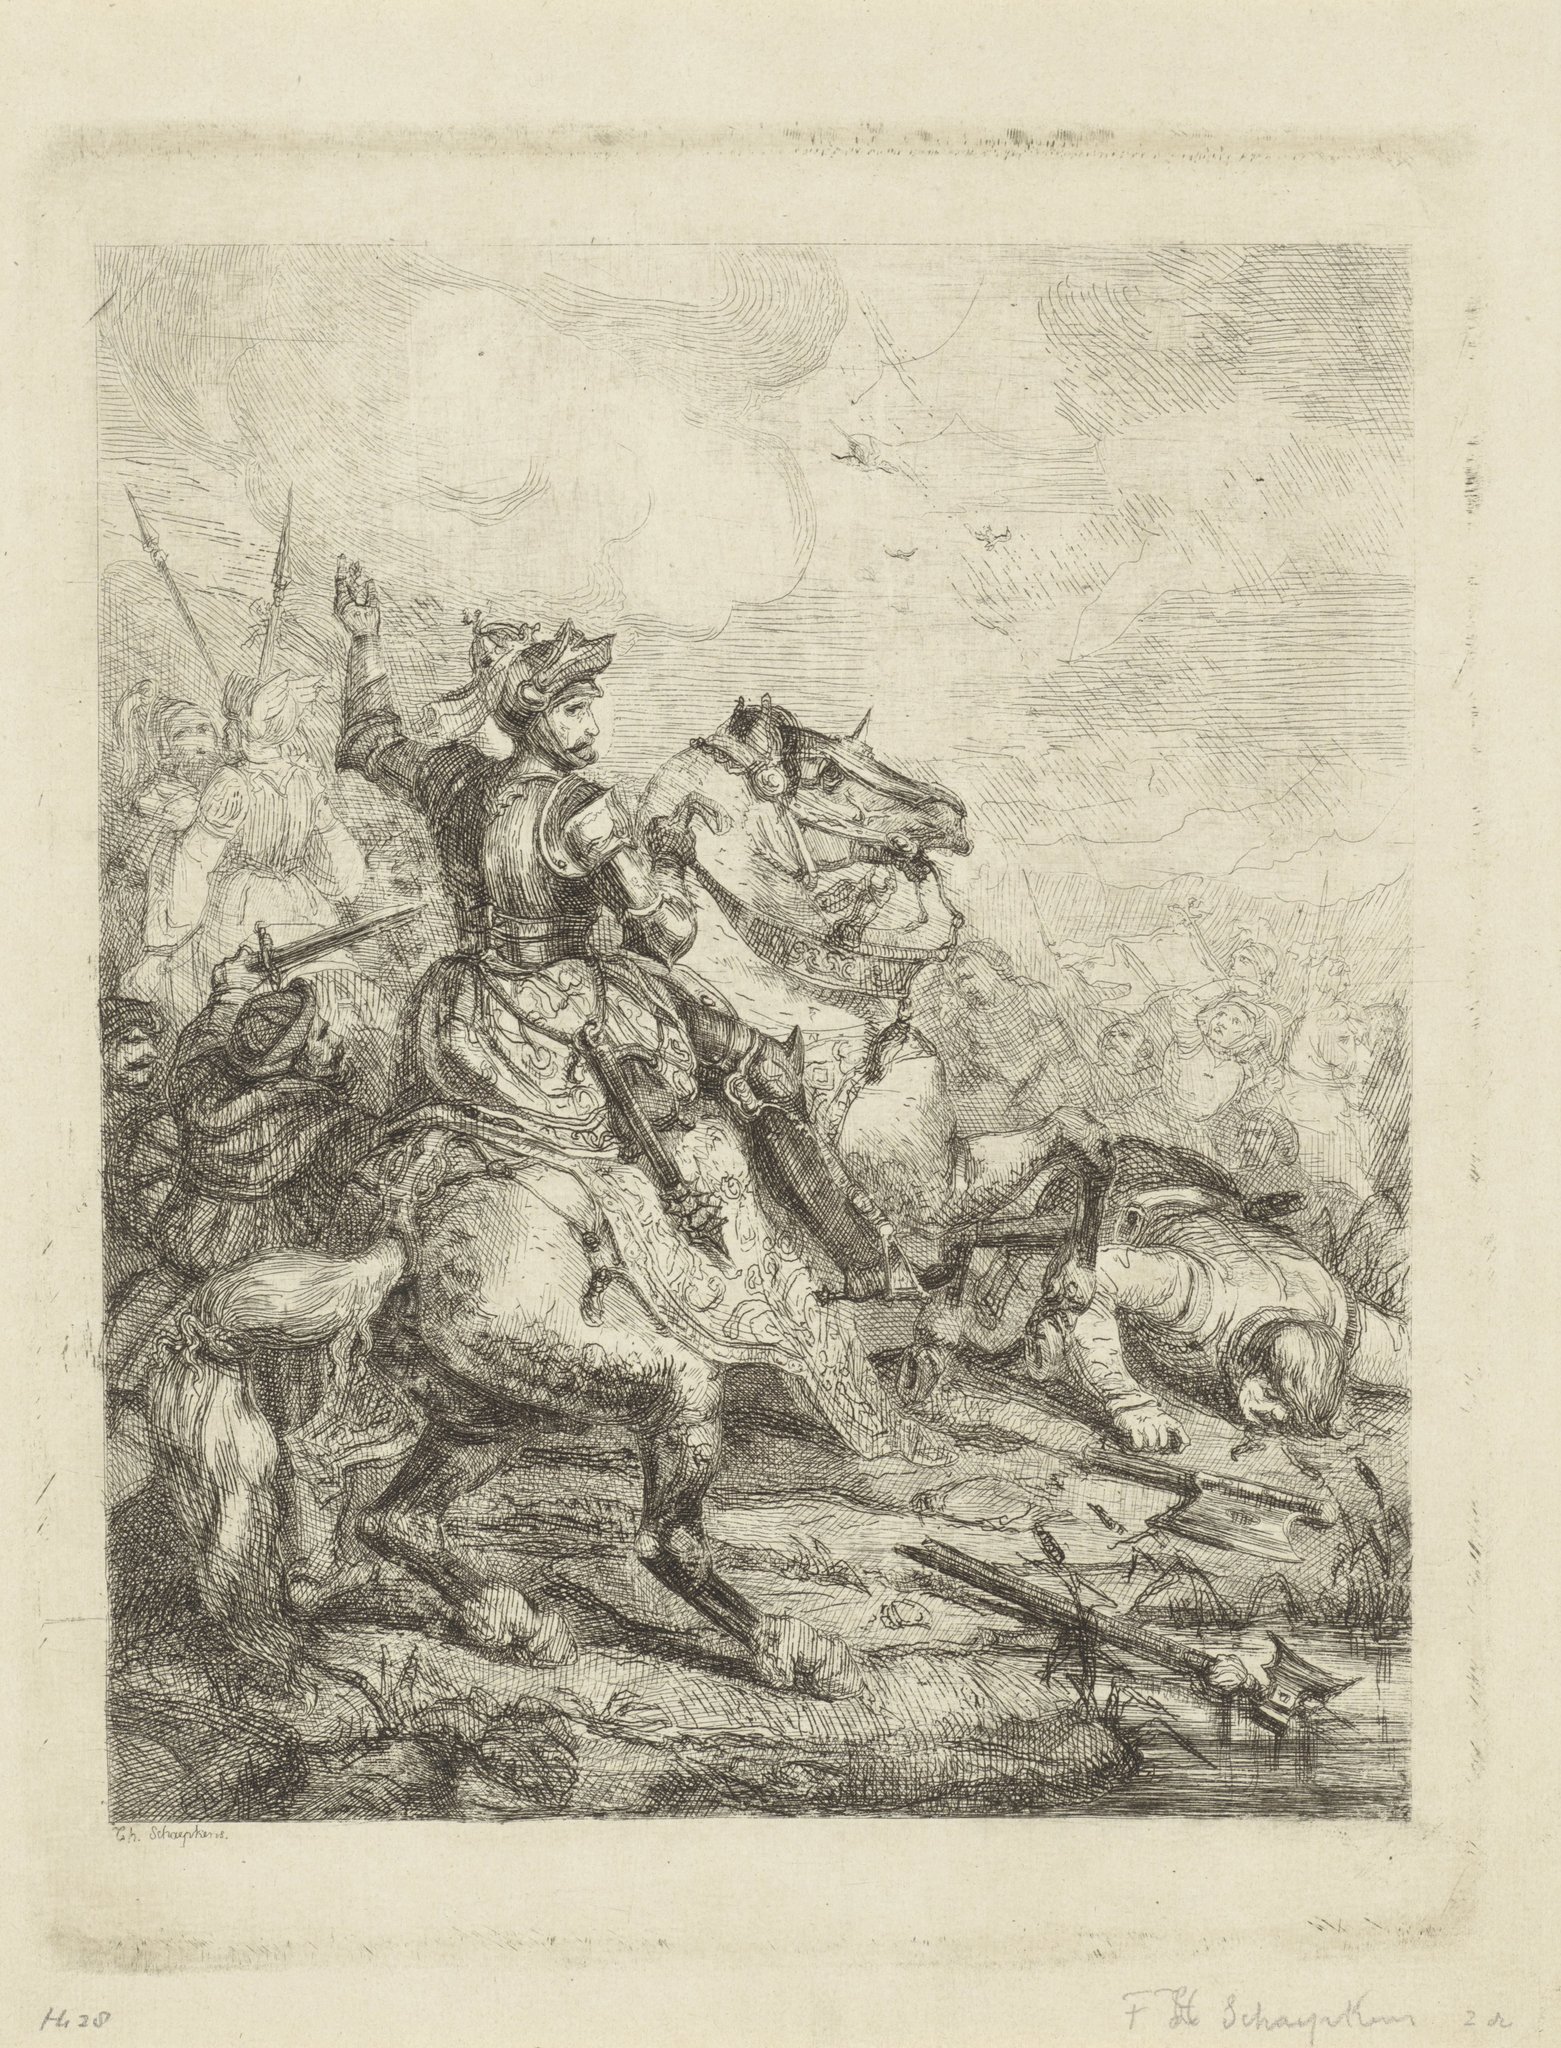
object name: print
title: Keizer Hendrik II de Heilige te paard in een veldslag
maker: theodoor schaepkens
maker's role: draughtsman, print maker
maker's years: 1810-1883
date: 1835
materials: paper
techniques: etching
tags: battle, military discipline (+ cavalry, horsemen)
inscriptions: collector's mark: Lugt 2228